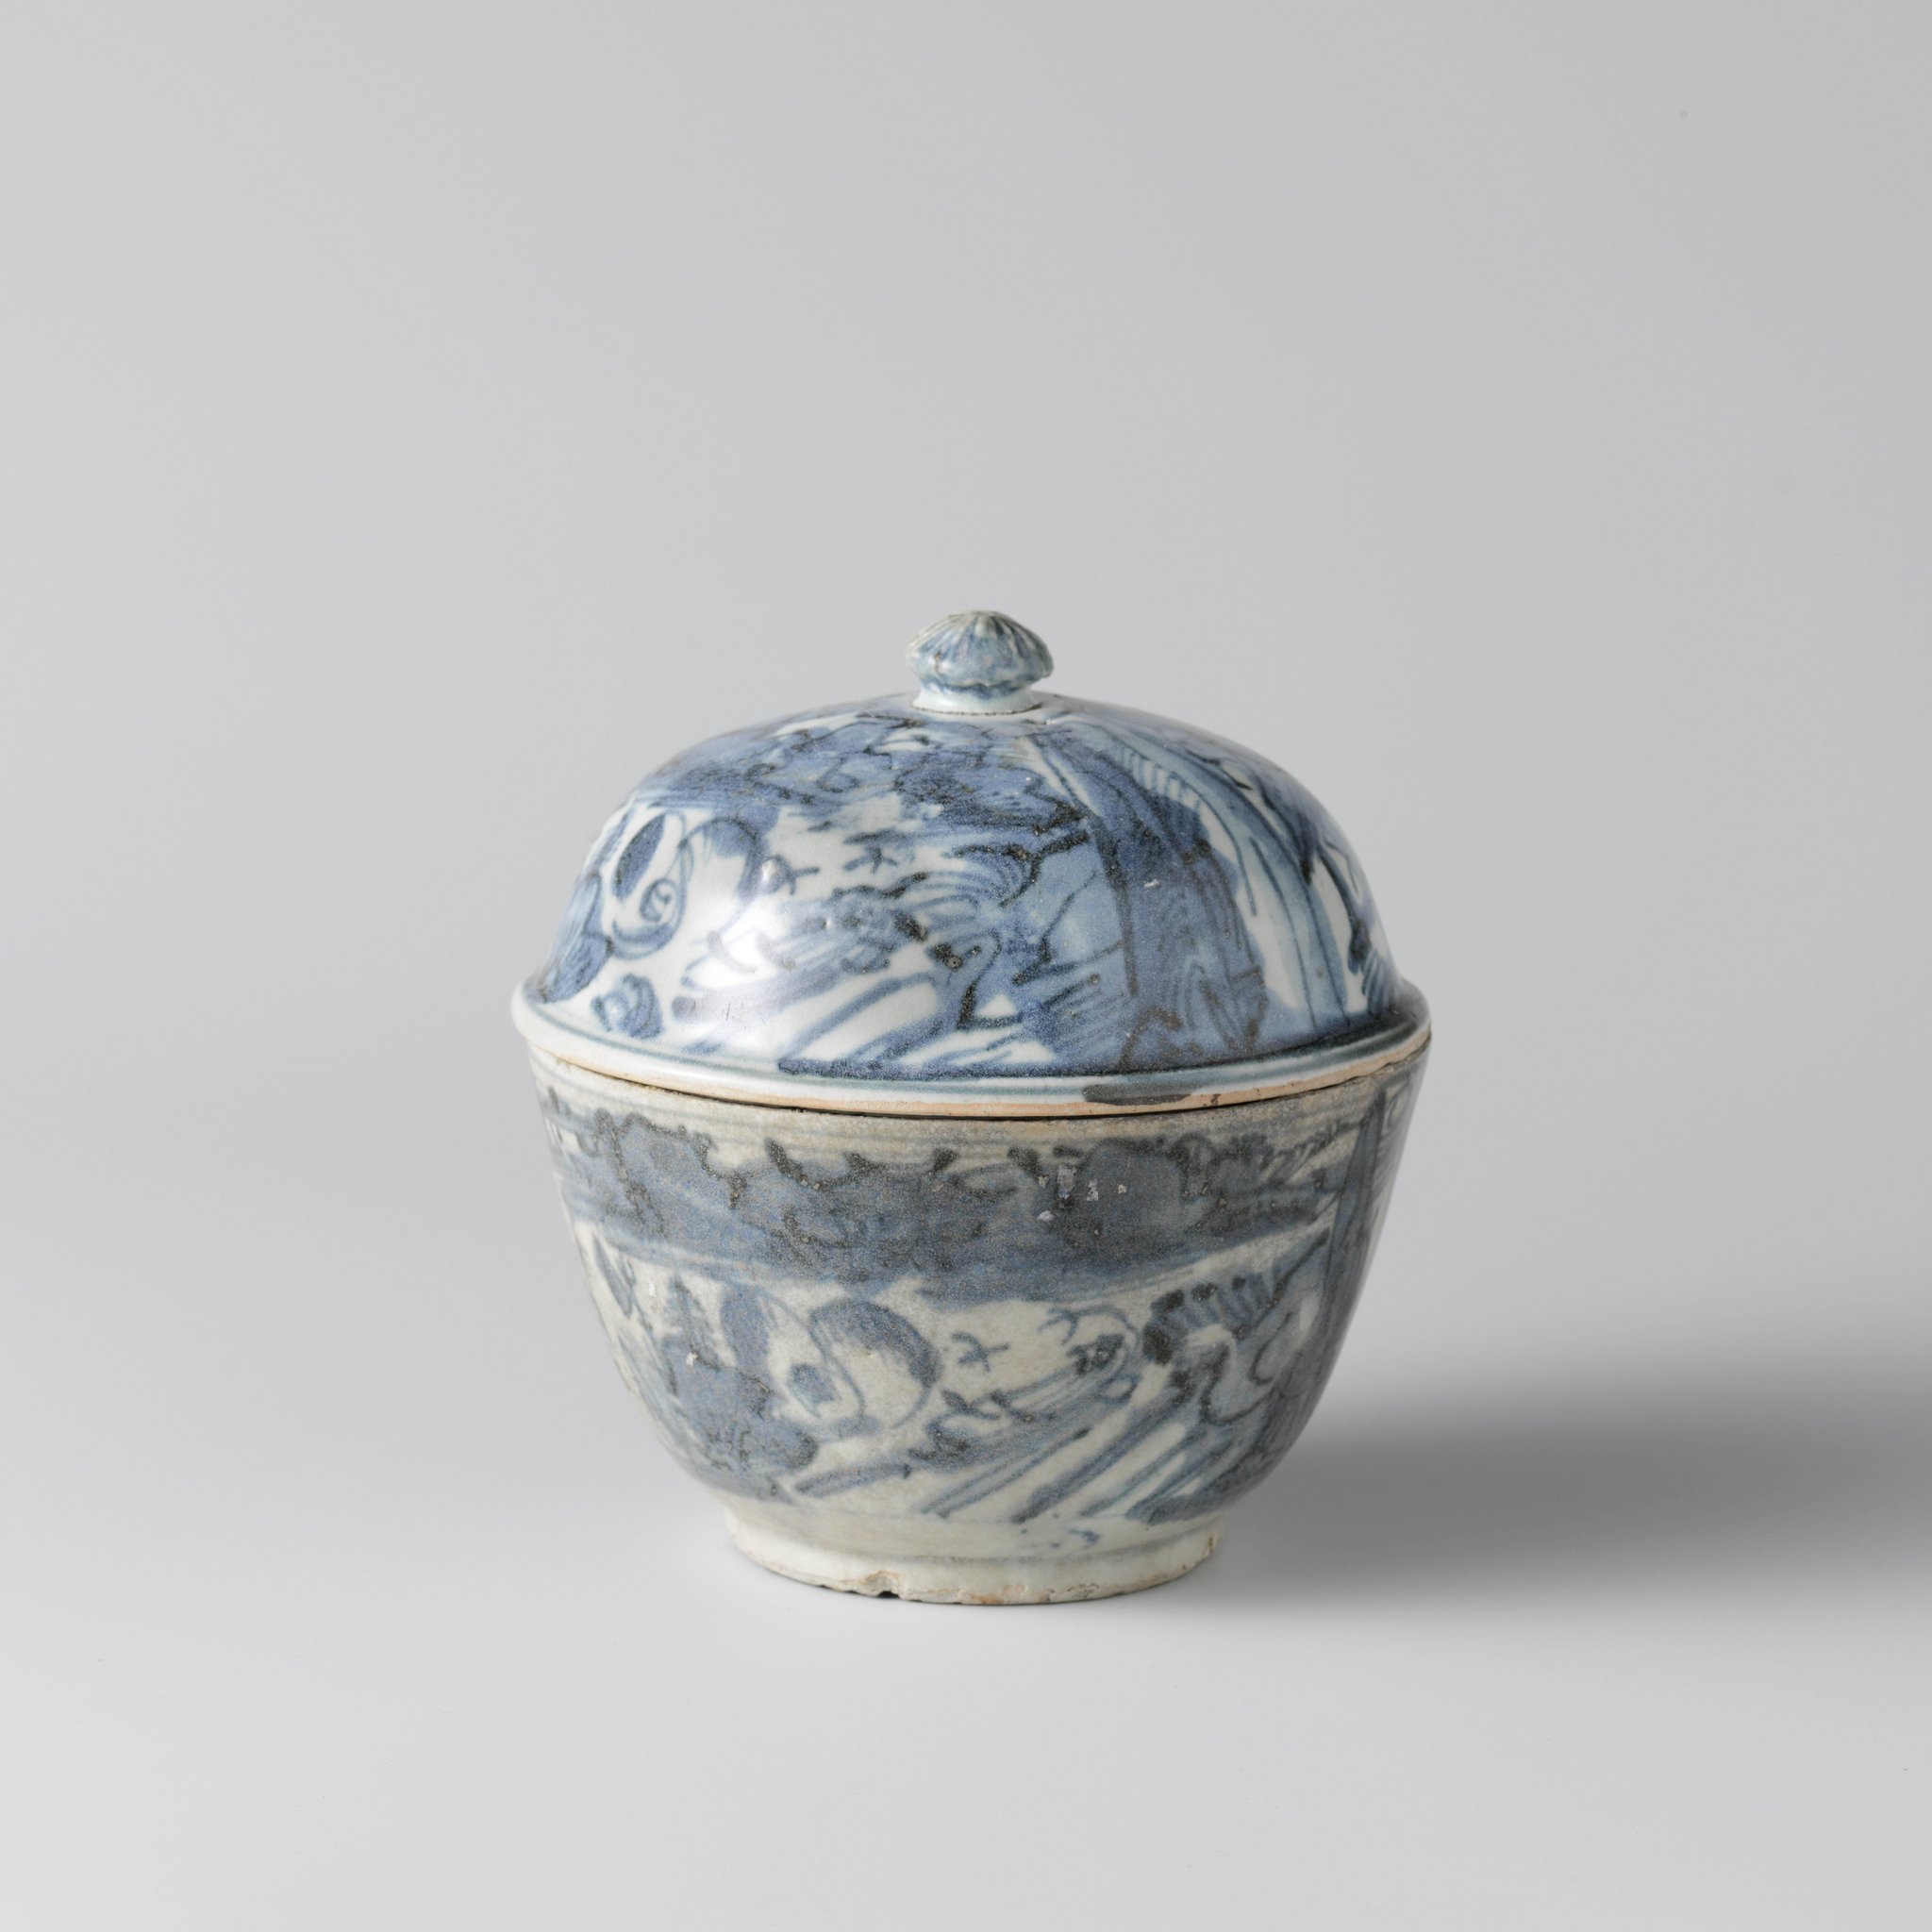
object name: bowl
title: Kom met deksel uit V.O.C.-schip de 'Witte Leeuw'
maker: Anonymous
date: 1613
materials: porcelain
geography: jingdezhen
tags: verenigde oostindische compagnie, sint-helena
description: Kom met deksel uit V.O.C.-schip de 'Witte Leeuw', 100 % aanwezig. De kom heeft een hoge wand die bijna recht omhoog staat. De liprand is rond, dun en gefacetteerd. De deksel heeft een naar buiten lopende wand en een uitgeklapte rand. De liprand is ongeglazuurd en de dekselknop is onregelmatig gevormd. De voetring is v-vormig en gefacetteerd. De scherf kent enige verontreiniging. Het glazuur is dun, heeft barstjes en kent geen glans. De buitenzijde van de kom als ook de deksel is gedecoreerd met een landschap met heuvels, water en pagodes.